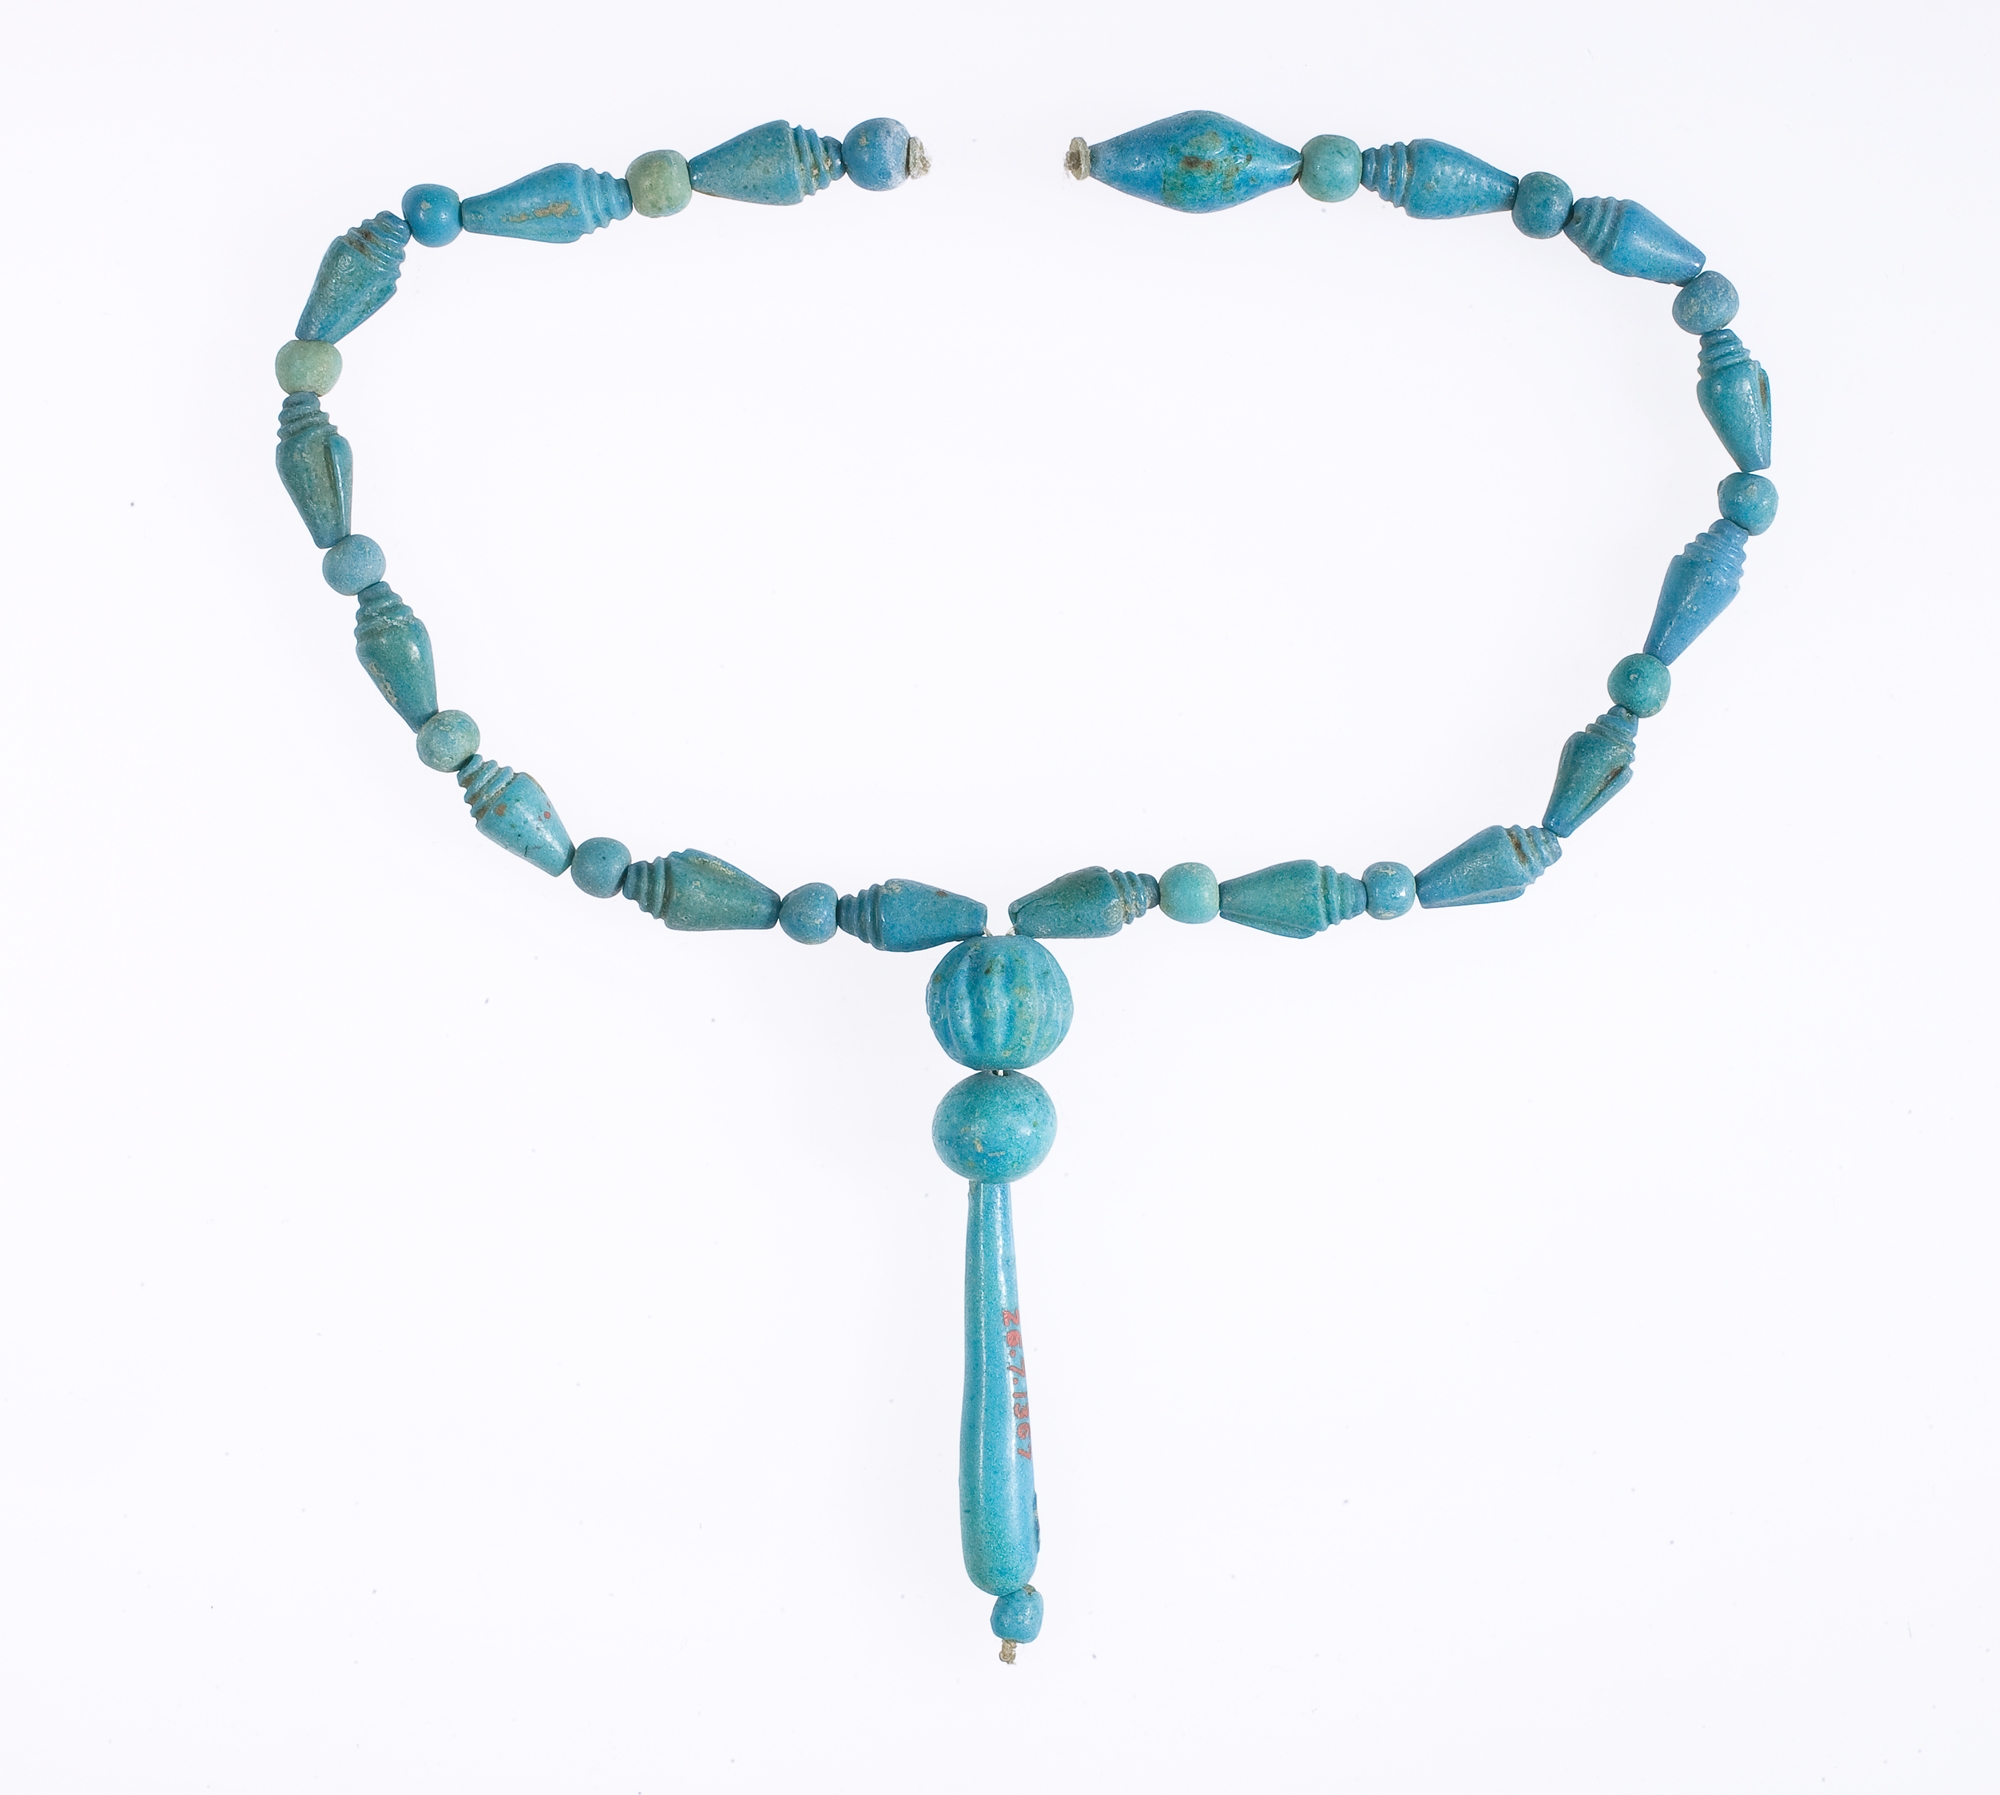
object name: bead, string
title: String of Beads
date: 1550-1425 BCE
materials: faience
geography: egypt